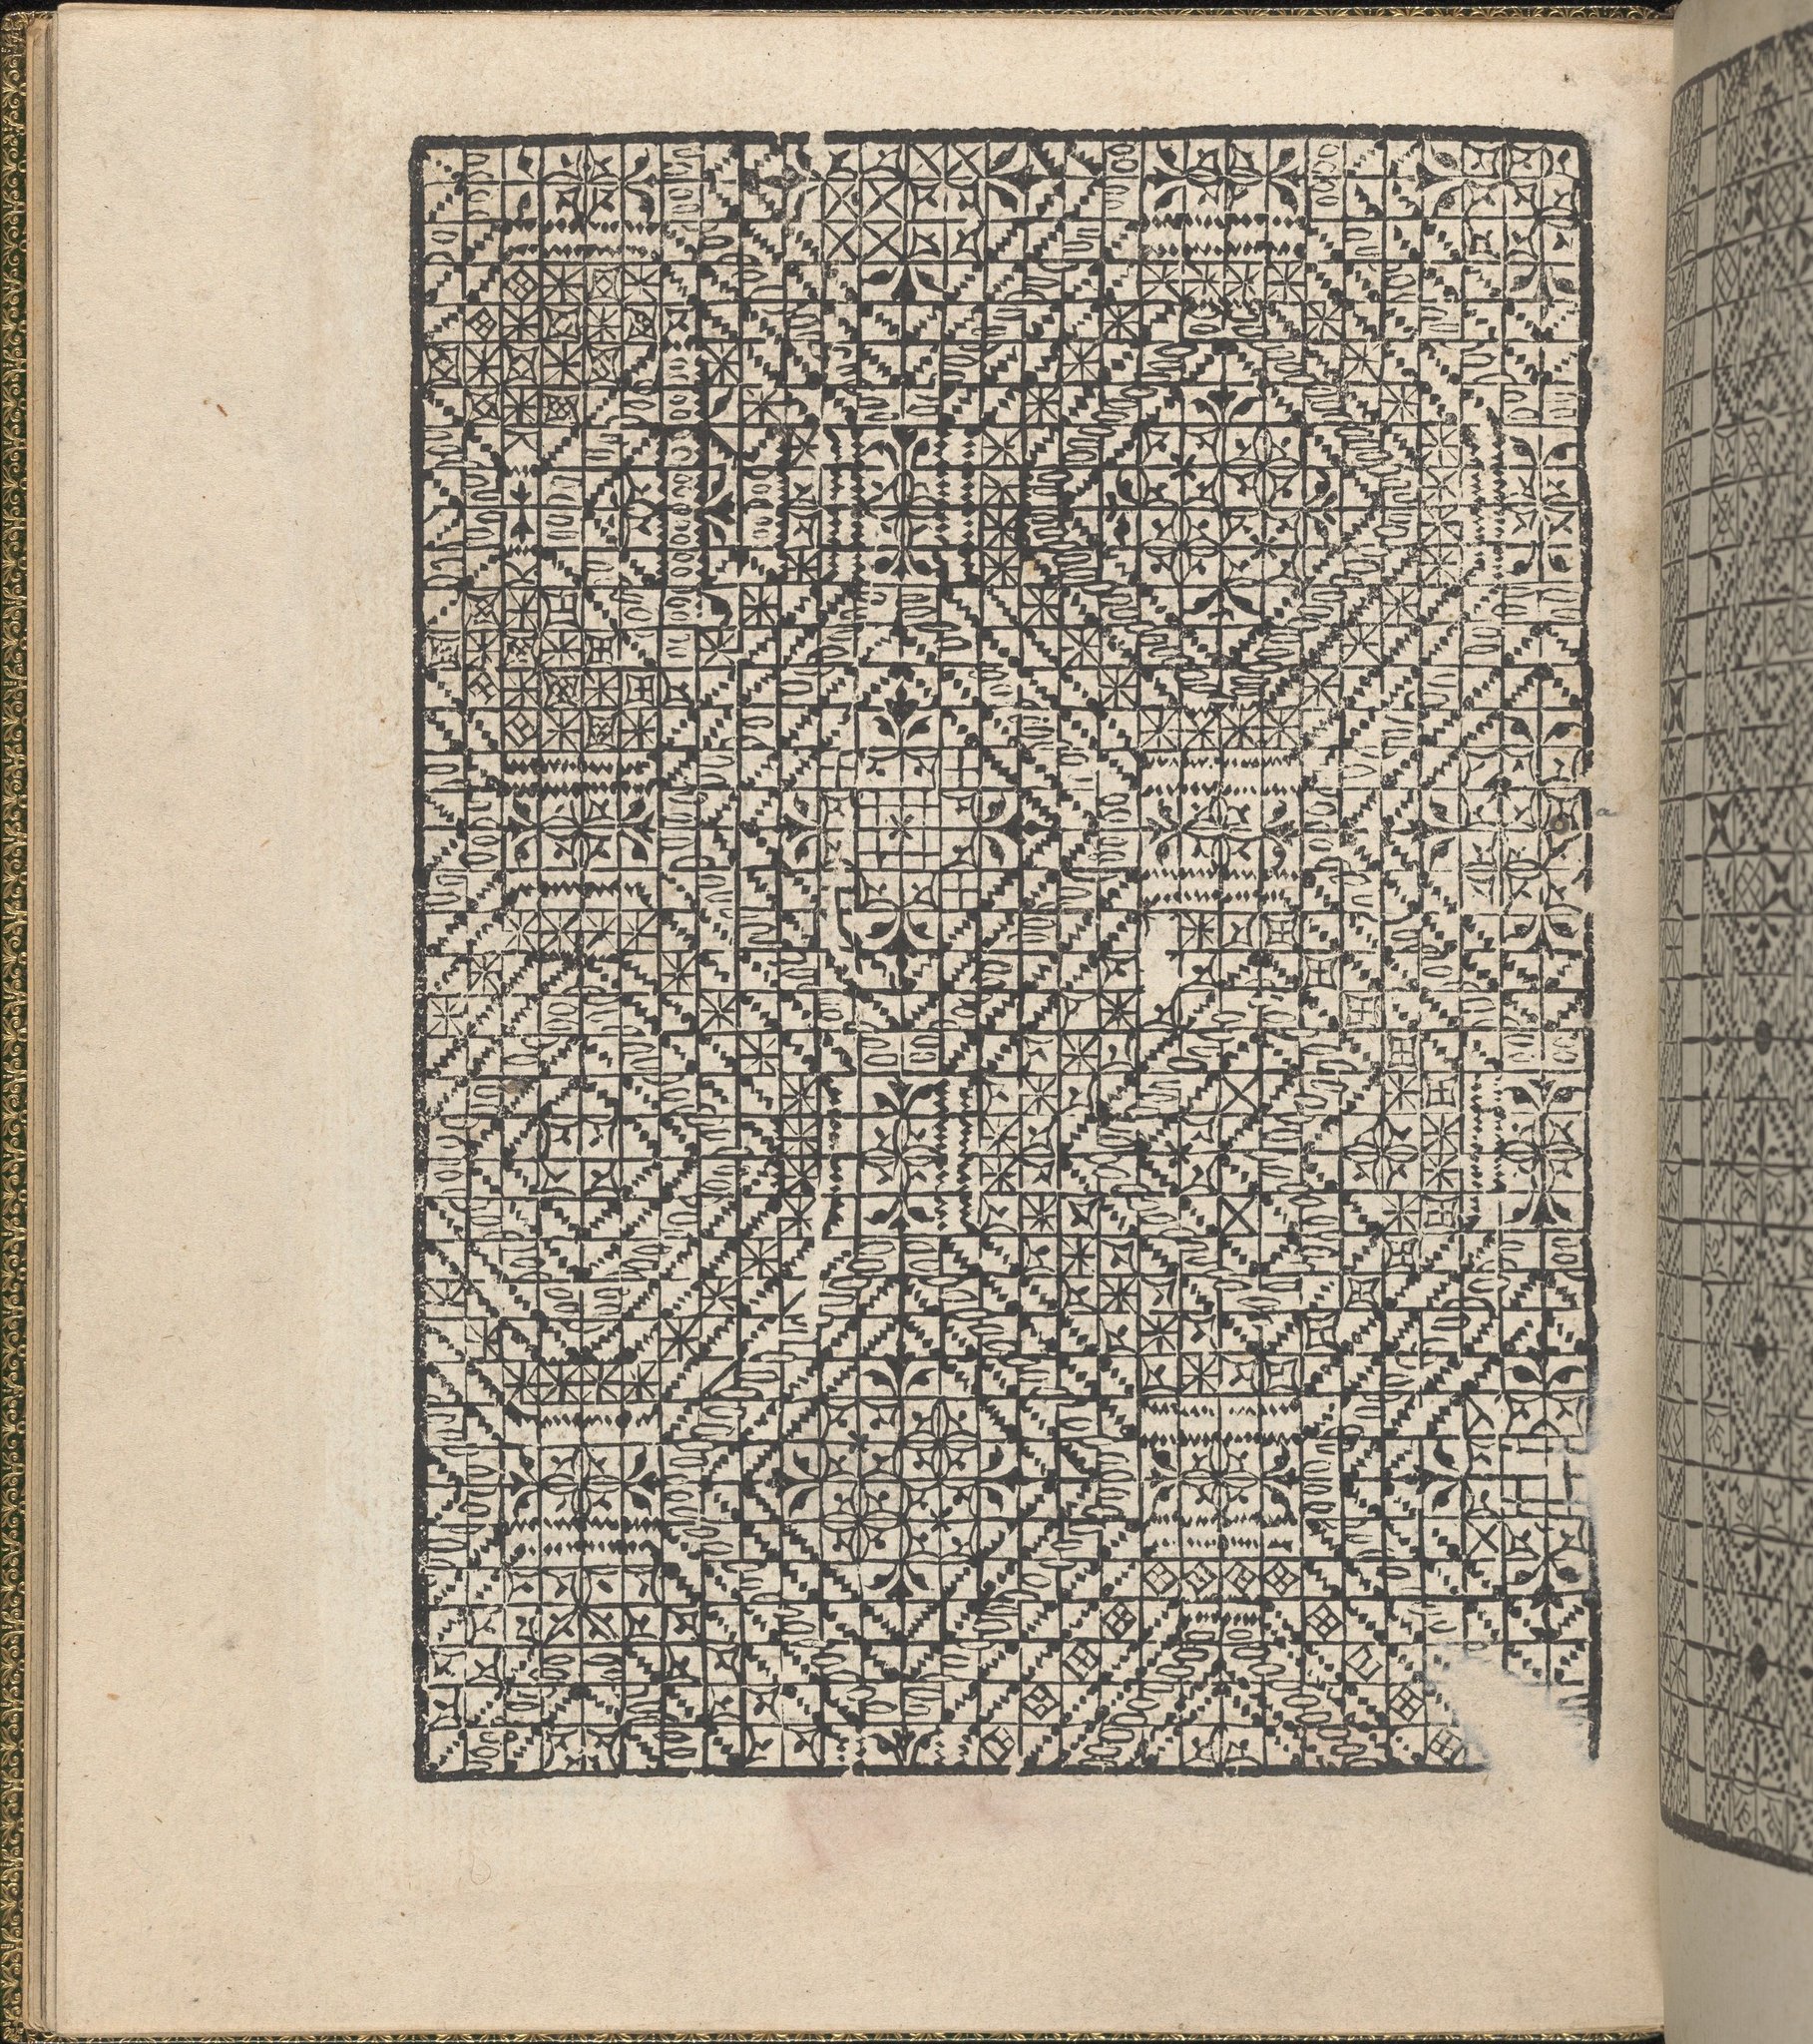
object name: book print ornament architecture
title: Giardineto novo di punti tagliati et gropposi per exercitio & ornamento delle donne (Venice 1554), page 22 (verso)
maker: matteo pagano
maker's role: publisher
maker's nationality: italian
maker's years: 1515-1588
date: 1554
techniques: woodcut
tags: ornament